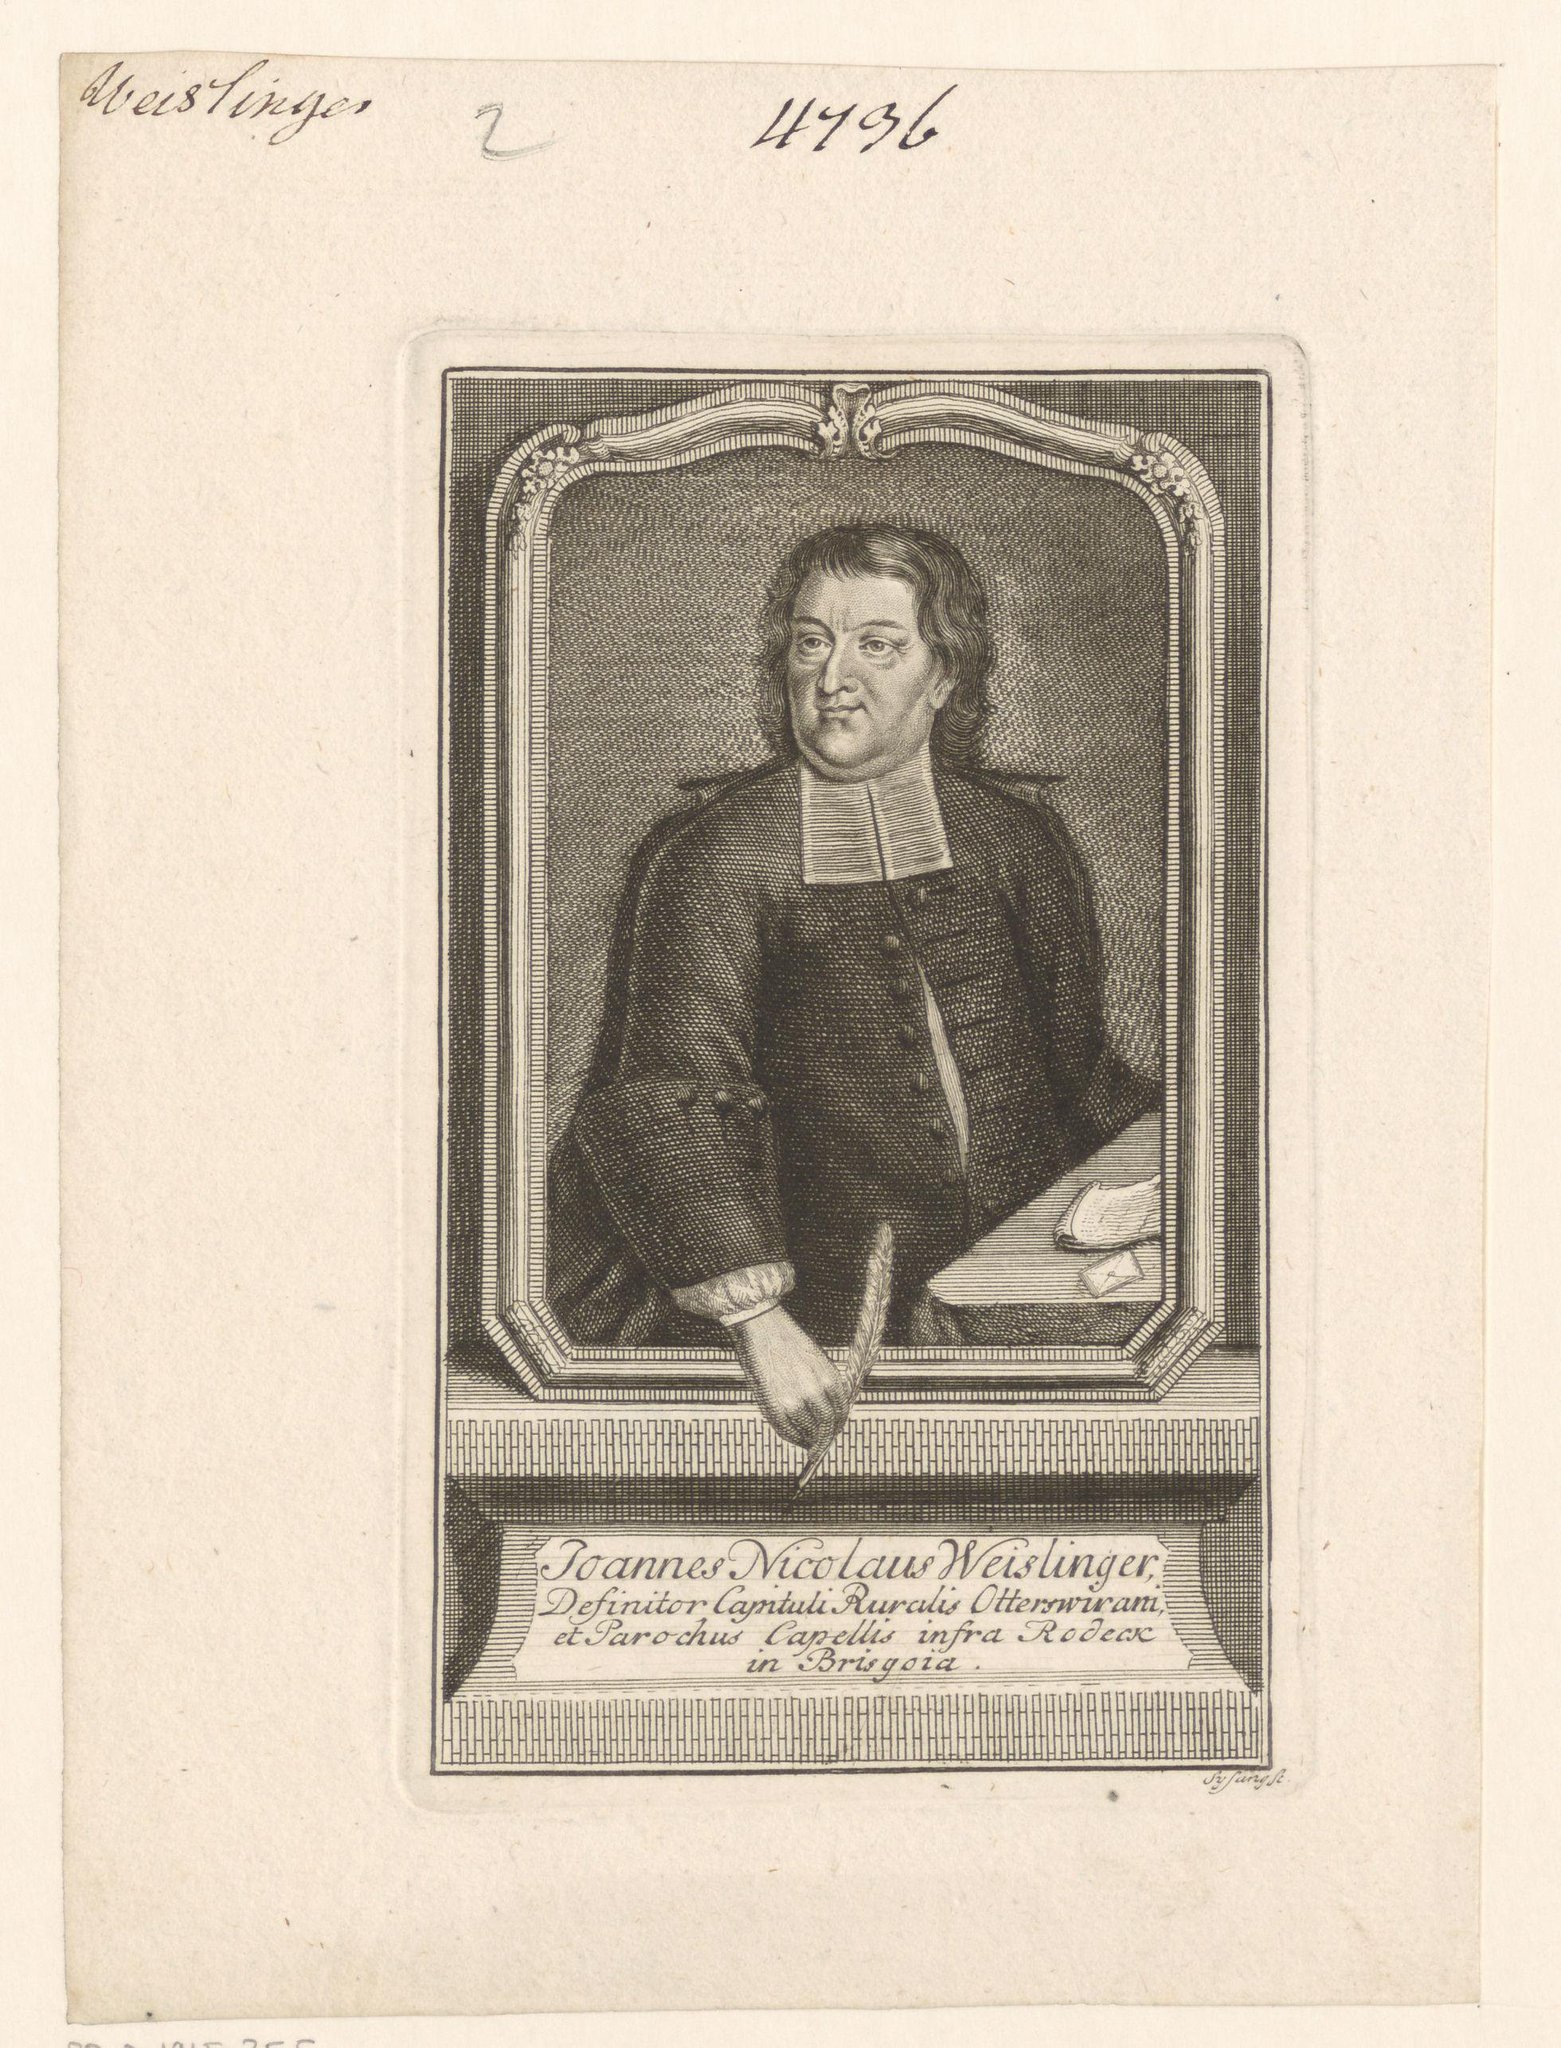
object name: print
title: Portret van Johann Nicolaus Weislinger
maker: johann christoph sysang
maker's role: print maker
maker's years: 1703-1757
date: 1730-1757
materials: paper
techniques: engraving, etching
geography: germany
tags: writing tools, historical persons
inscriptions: collector's mark: Lugt 2228, number: ‘4736’